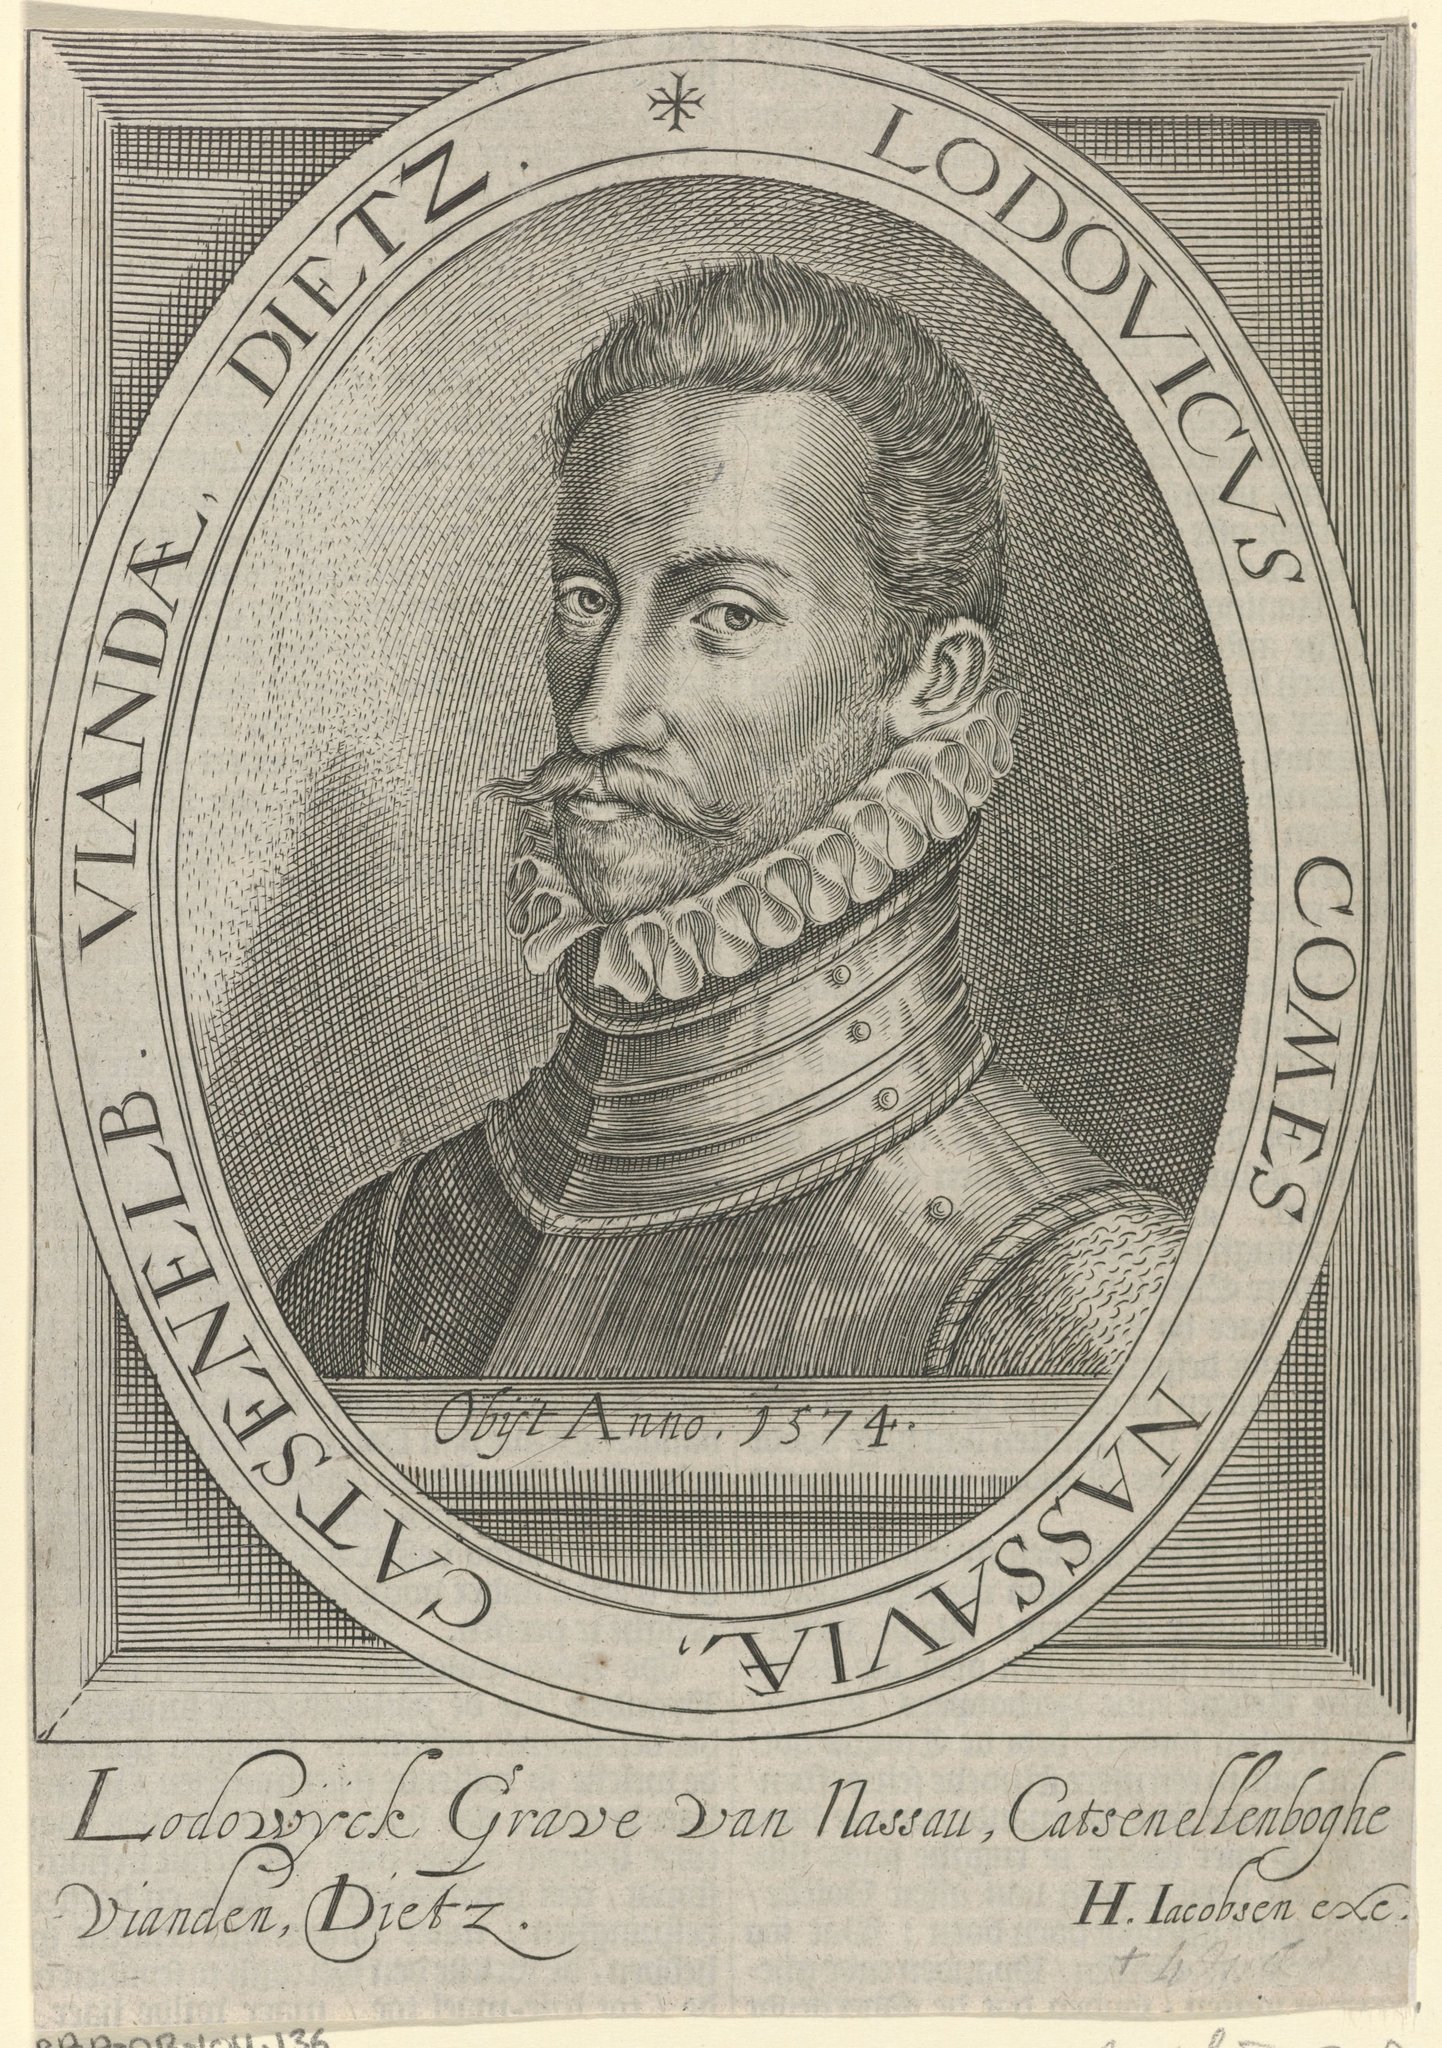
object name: print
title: Portret van Lodewijk, graaf van Nassau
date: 1602-1622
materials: paper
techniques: engraving, etching, letterpress printing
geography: low countries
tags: dillenburg, mookerheide, lodewijk graaf van nassau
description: De hier vermelde titel verwijst naar de hoogst verkregen titel van de geportretteerde, niet per se naar de titel die de geportretteerde op deze voorstelling draagt.